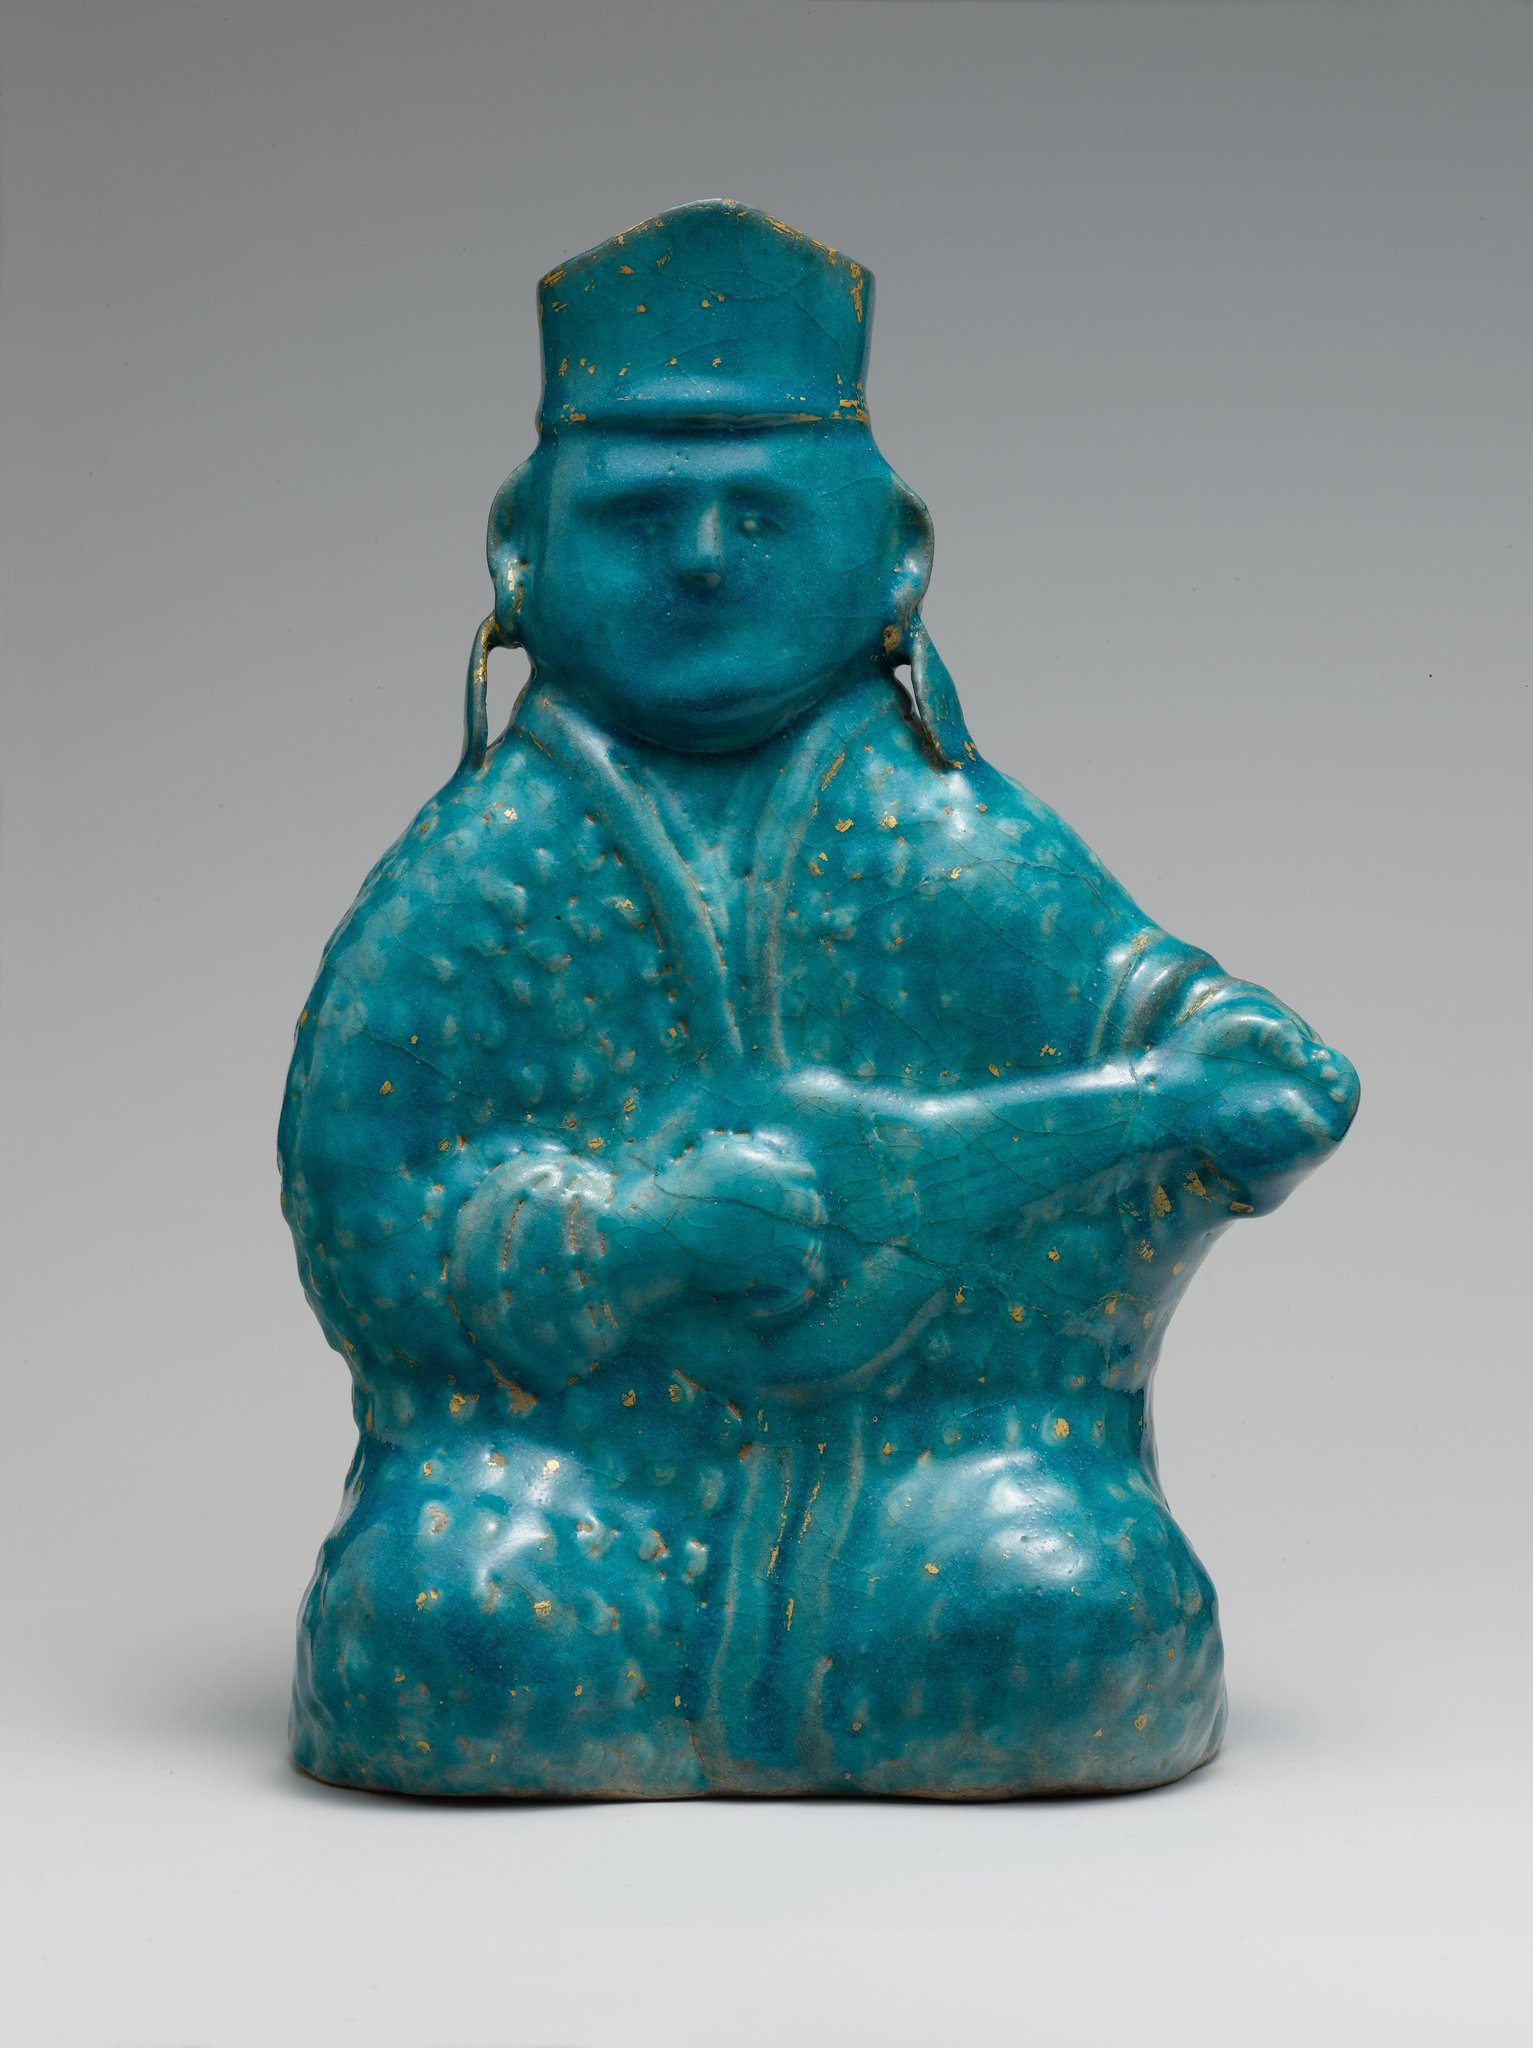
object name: figural vessel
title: Bottle in the Form of a Lute Player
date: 1901-1933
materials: stonepaste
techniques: gilding, glazing, molding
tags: human figures,lutes